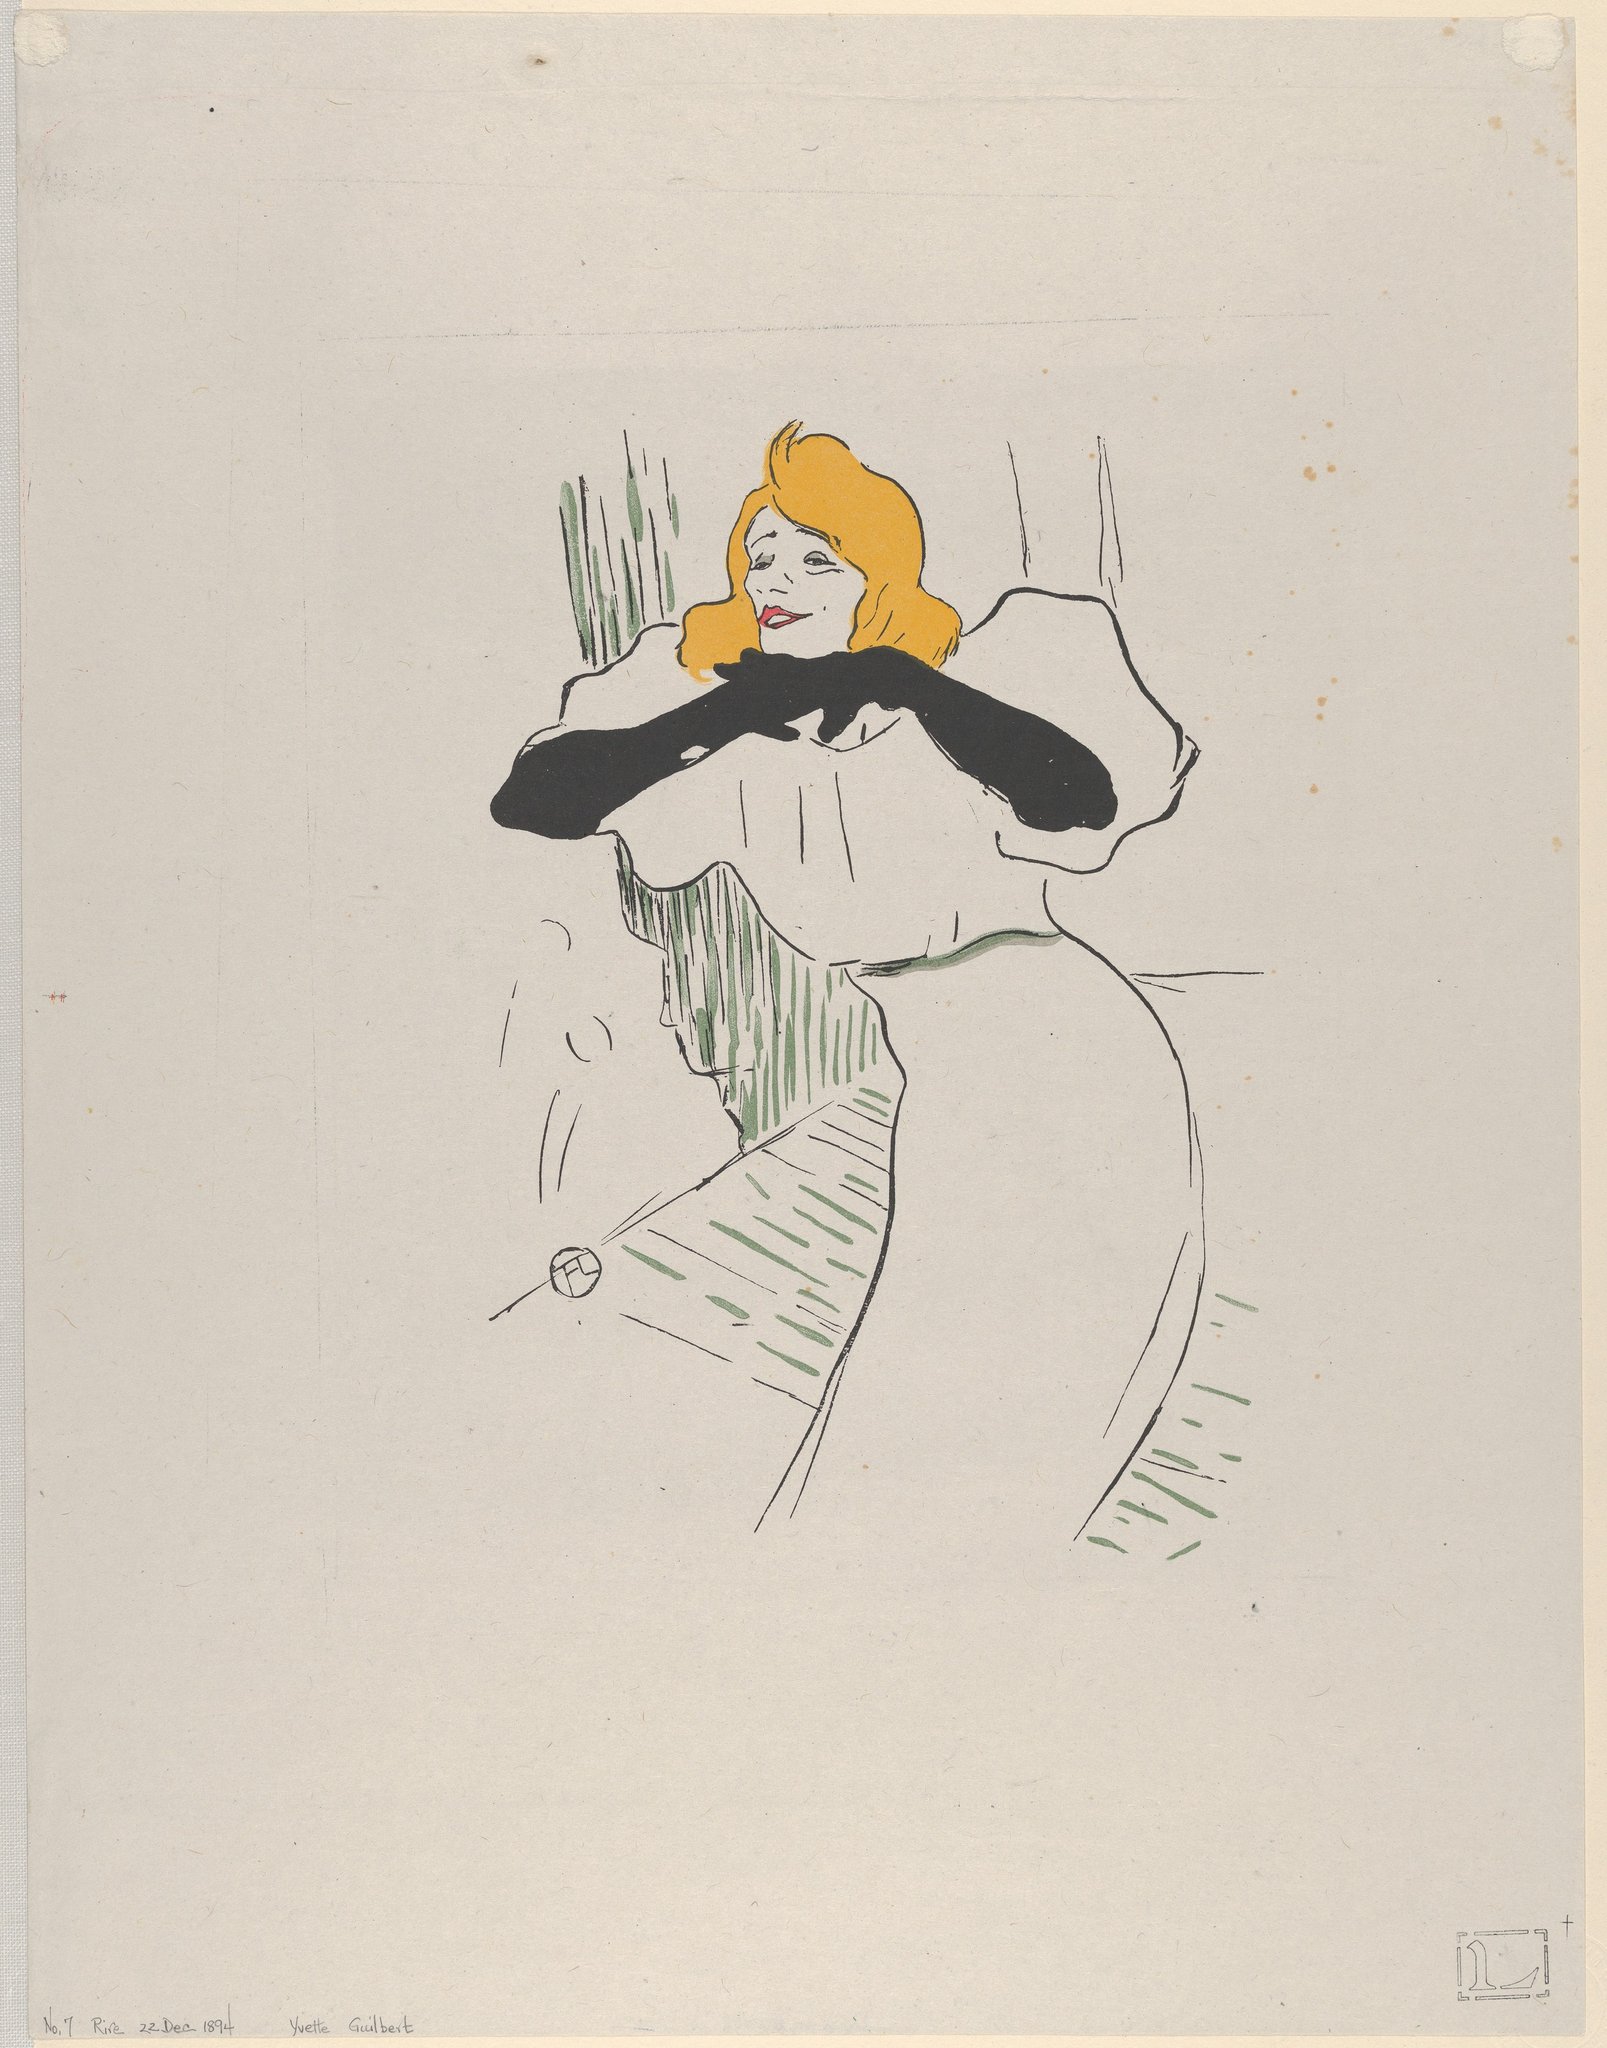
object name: print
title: Yvette Guilbert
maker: henri de toulouse-lautrec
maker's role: artist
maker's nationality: french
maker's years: 1864-1901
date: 1894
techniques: lithograph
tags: women